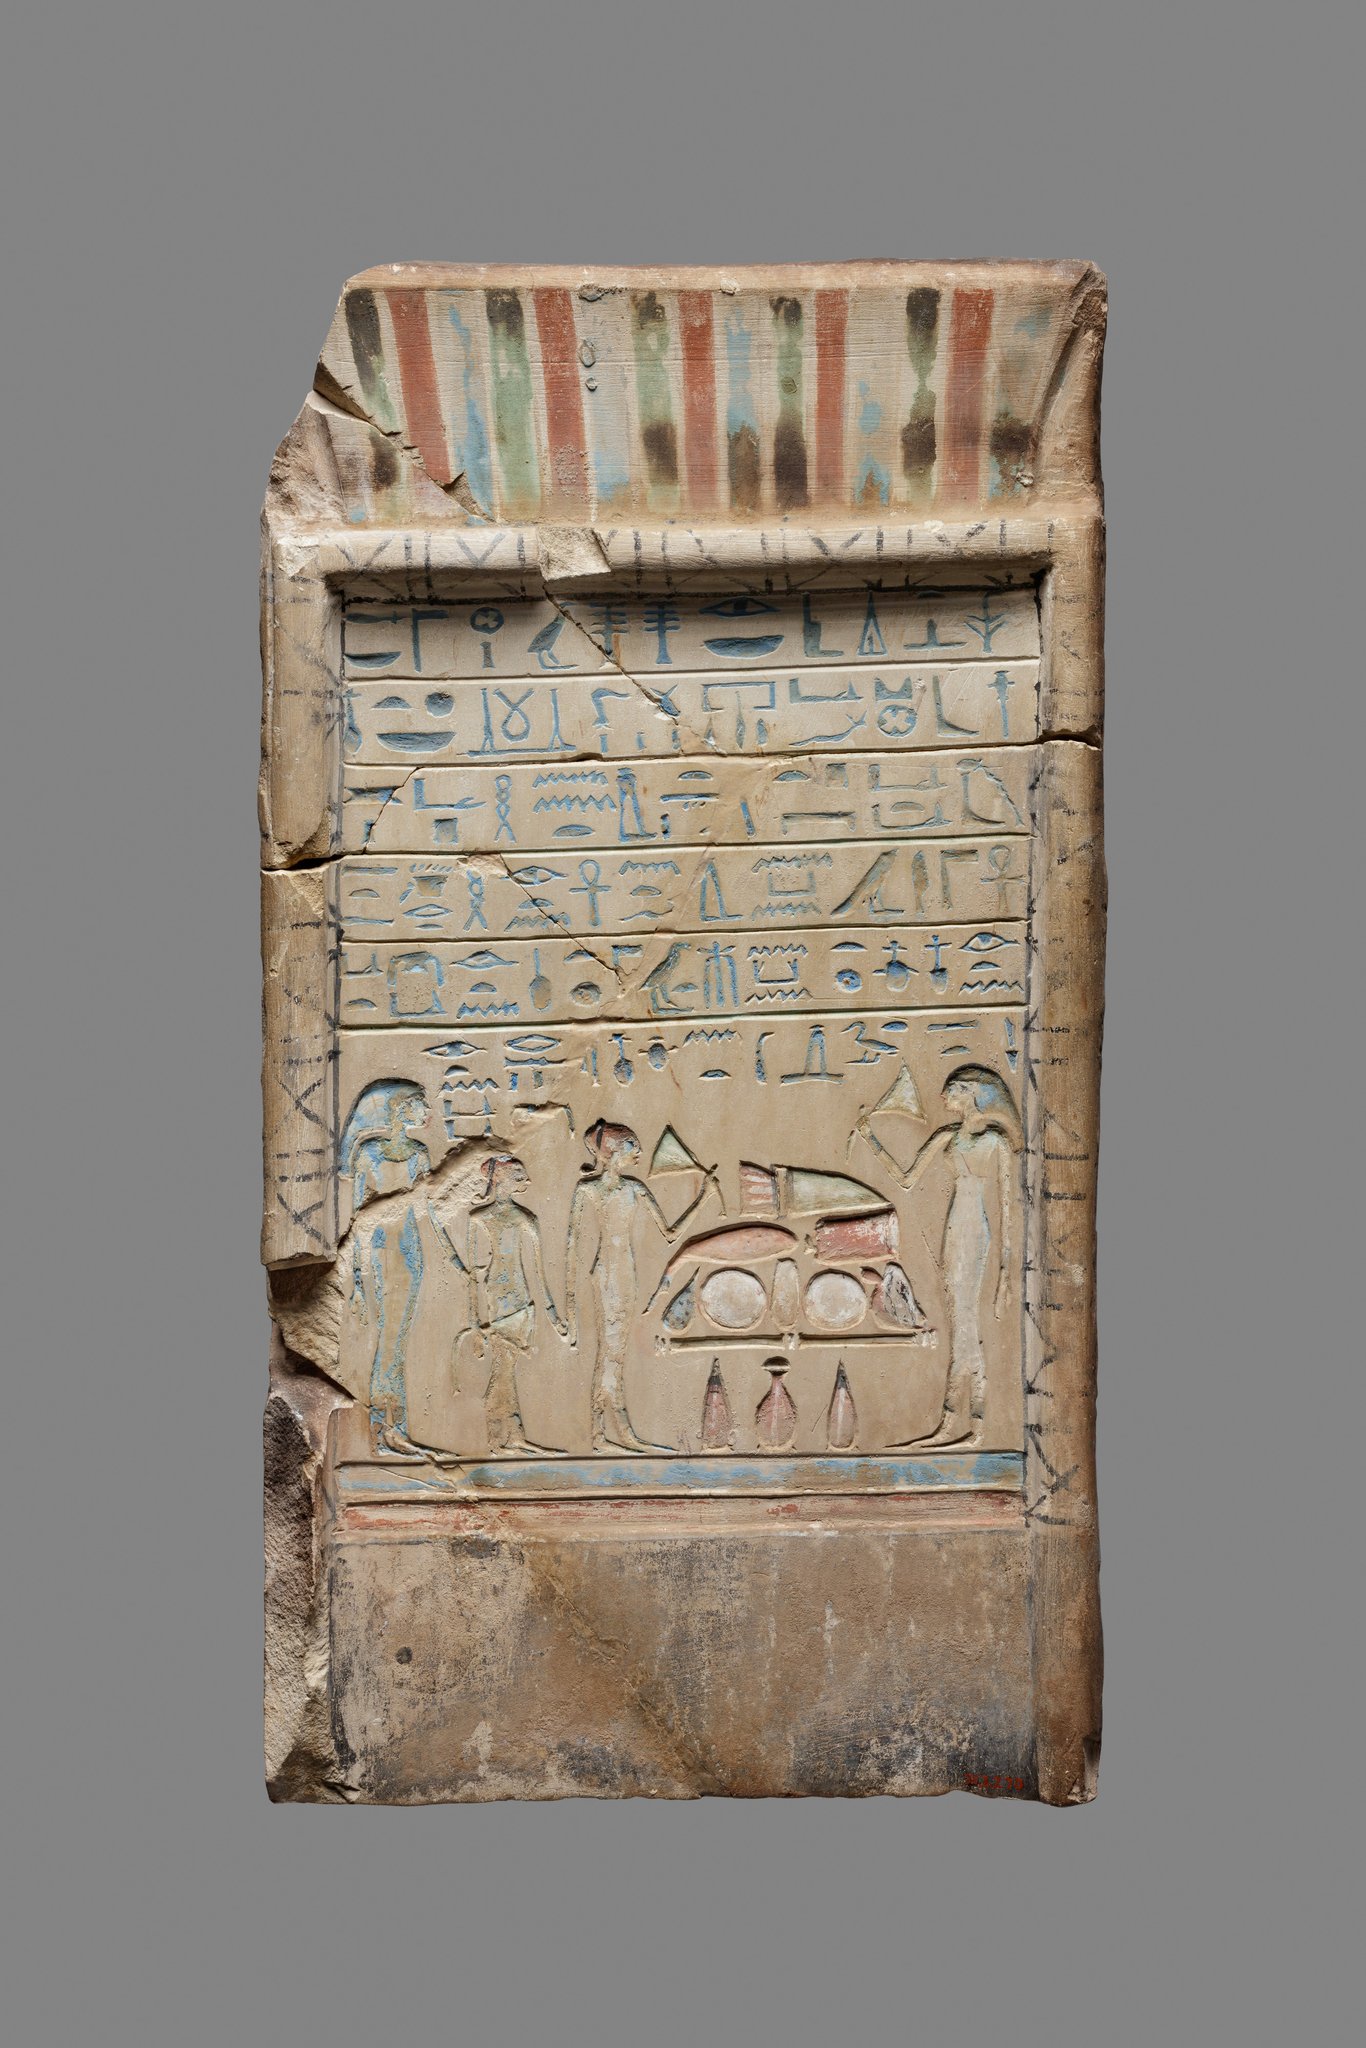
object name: stela, tekhnefer, intefankh, mesutnetjer tekhnefer, tanetib neferseresu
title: Stela of Four Women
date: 1802-1650 BCE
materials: limestone, paint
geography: egypt